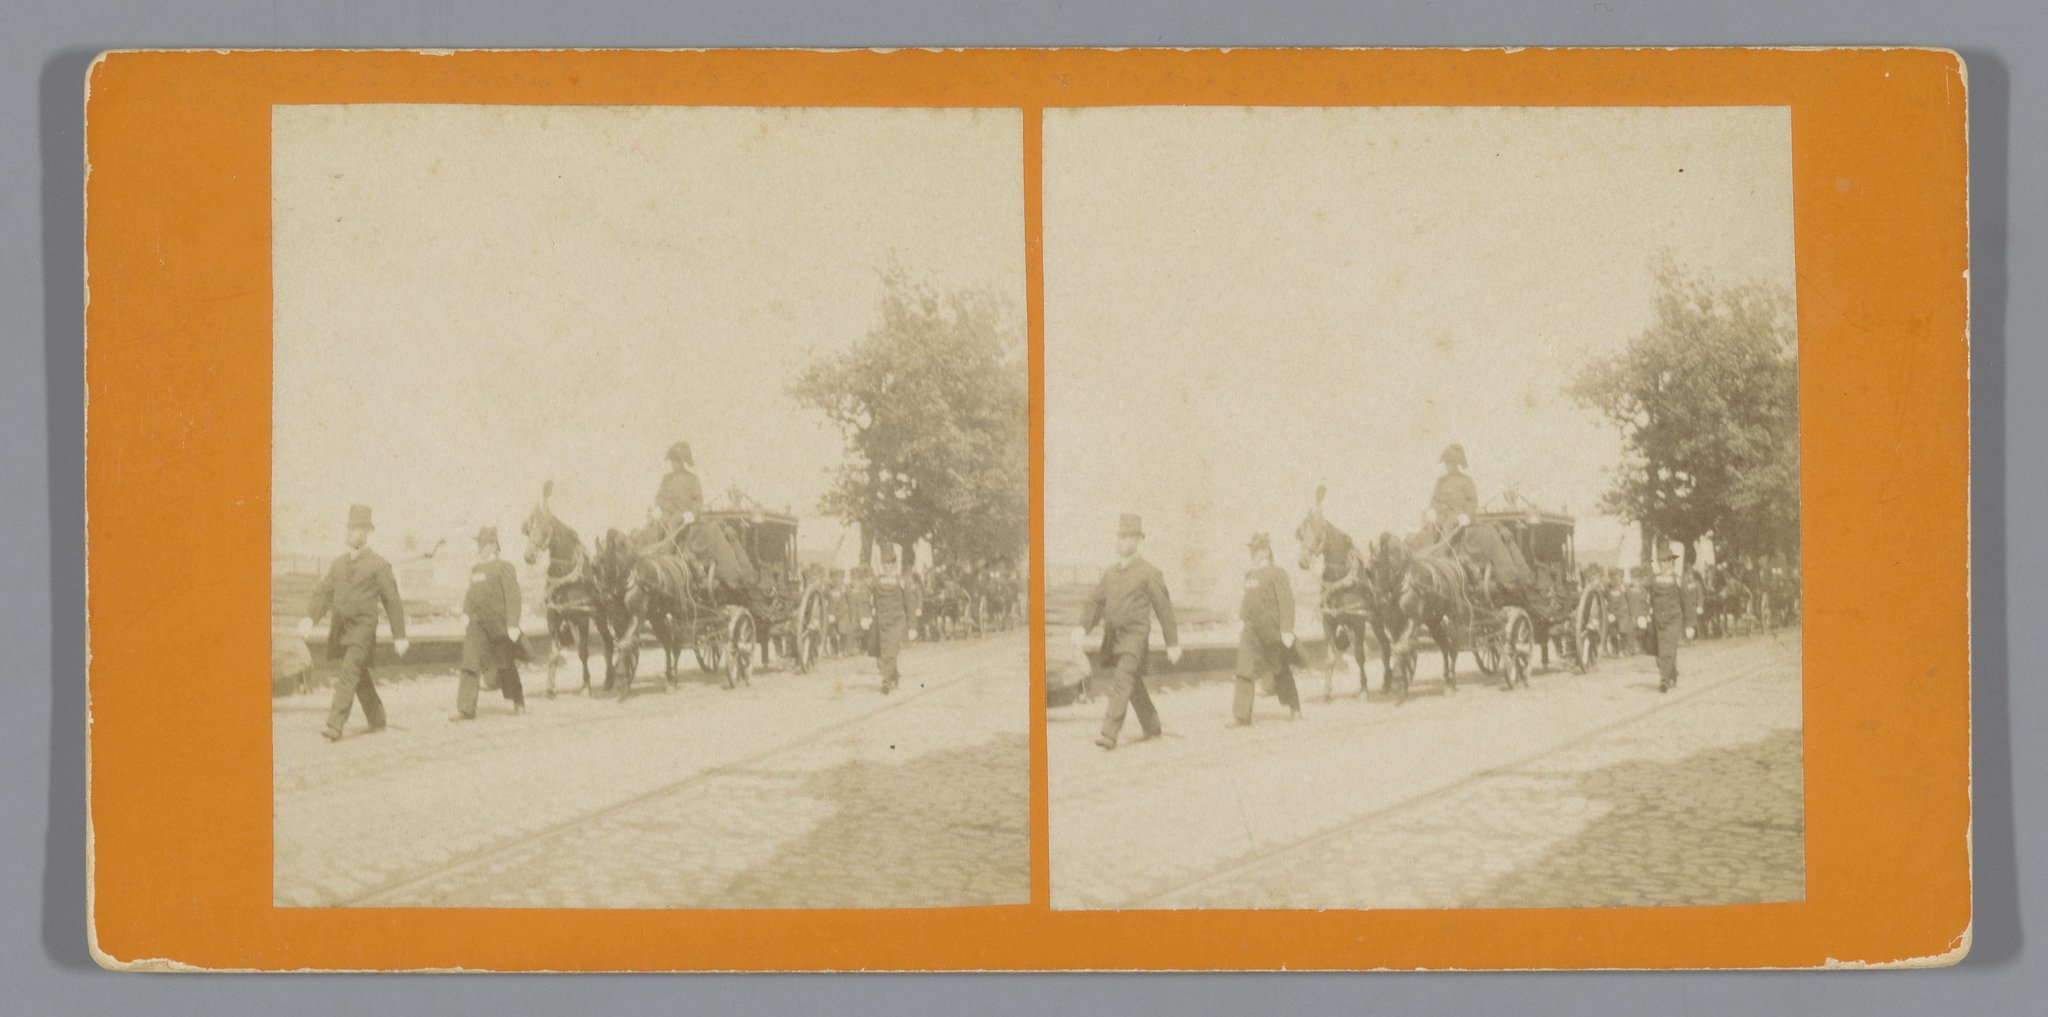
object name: stereograph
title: Rouwstoet met een koets getrokken door paarden, Amsterdam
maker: Anonymous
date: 1897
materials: cardboard, paper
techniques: albumen print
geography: amsterdam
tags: cortege, funeral procession, amsterdam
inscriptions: stamp: ‘CHR. HERMANS/ RIJKSWEG ZUID 55D/ SITTARD.’, inscription: ‘lijkstatie t Amst. 97’